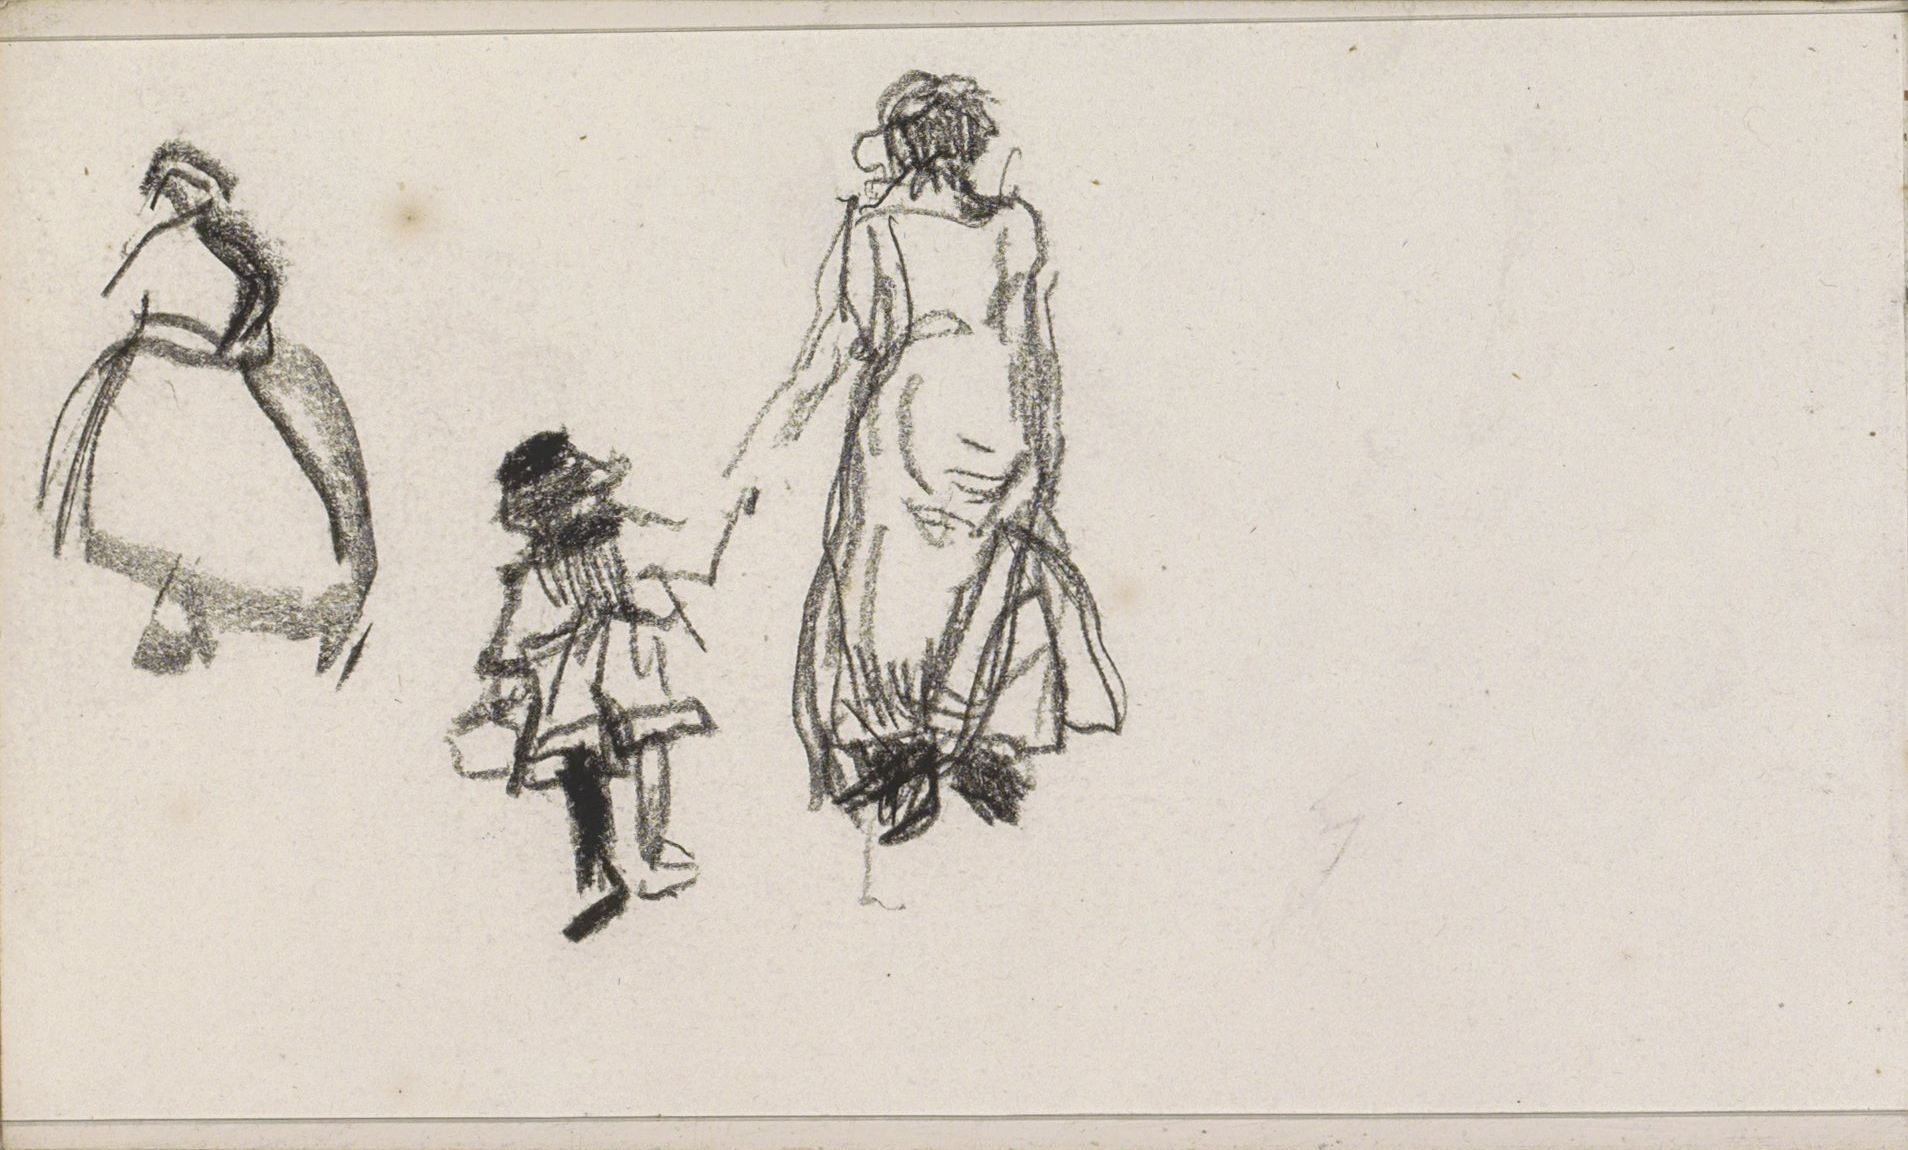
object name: sketchbook leaf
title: Vrouw met meisje aan de hand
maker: isaac israels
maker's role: draughtsman, painter, print maker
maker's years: 1865-1934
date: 1875-1934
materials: chalk, paper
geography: the hague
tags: adult woman, girl (child between toddler and youth)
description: Links nog een vrouw. Pagina 54 uit schetsboek XLVIII met 62 pagina's.